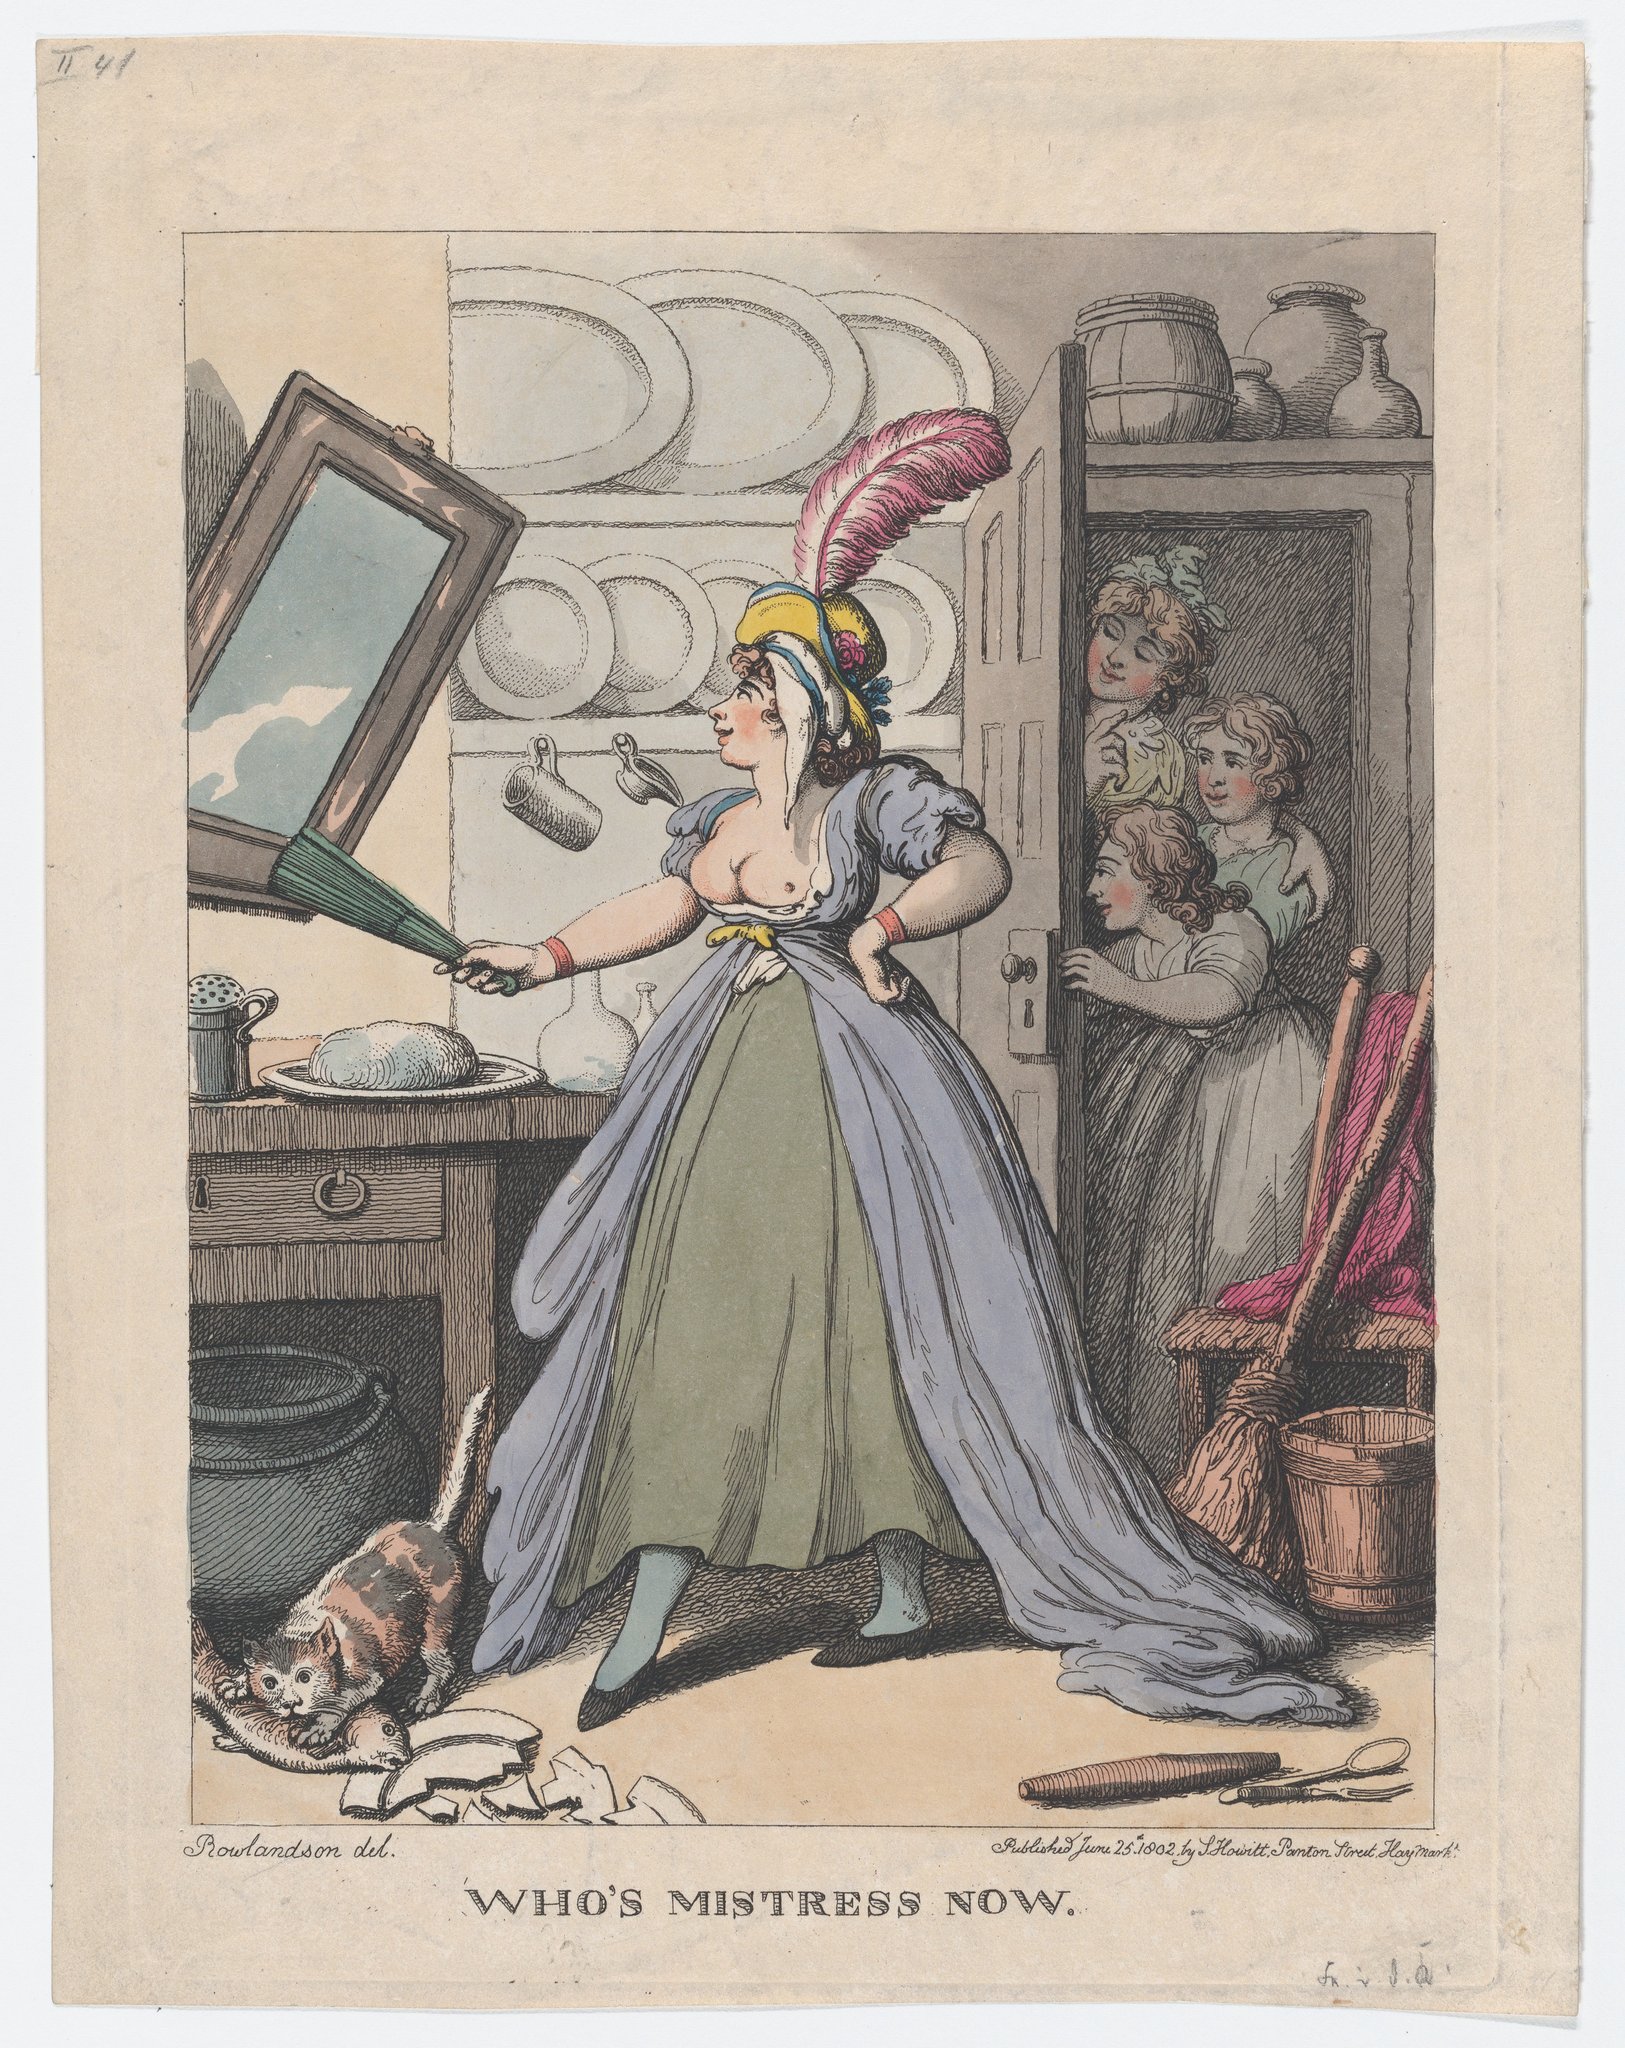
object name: print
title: Who's Mistress Now?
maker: thomas rowlandson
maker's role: artist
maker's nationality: british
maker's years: 1757-1827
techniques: etching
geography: england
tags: women,cats,mirrors